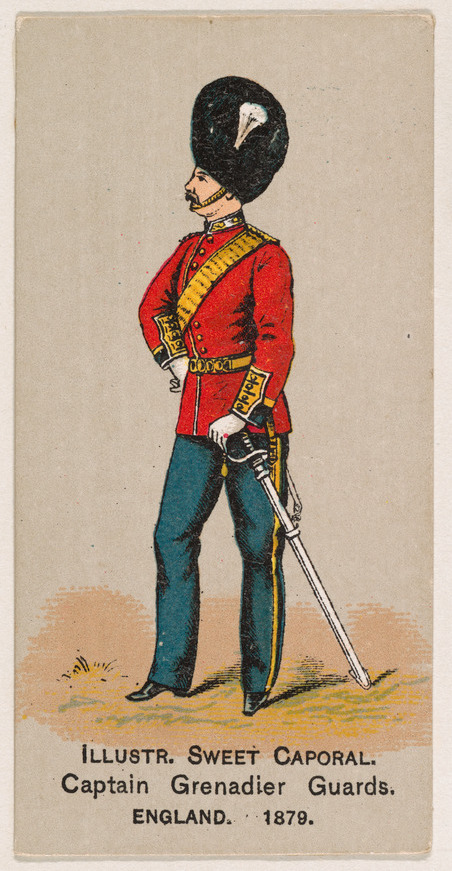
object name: print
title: Captain Grenadier Guards, England, 1879, from the Military Series (N224) issued by Kinney Tobacco Company to promote Sweet Caporal Cigarettes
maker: kinney brothers tobacco company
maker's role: publisher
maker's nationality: american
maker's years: 1869-2011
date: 1888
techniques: color lithograph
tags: military,swords,men,profiles